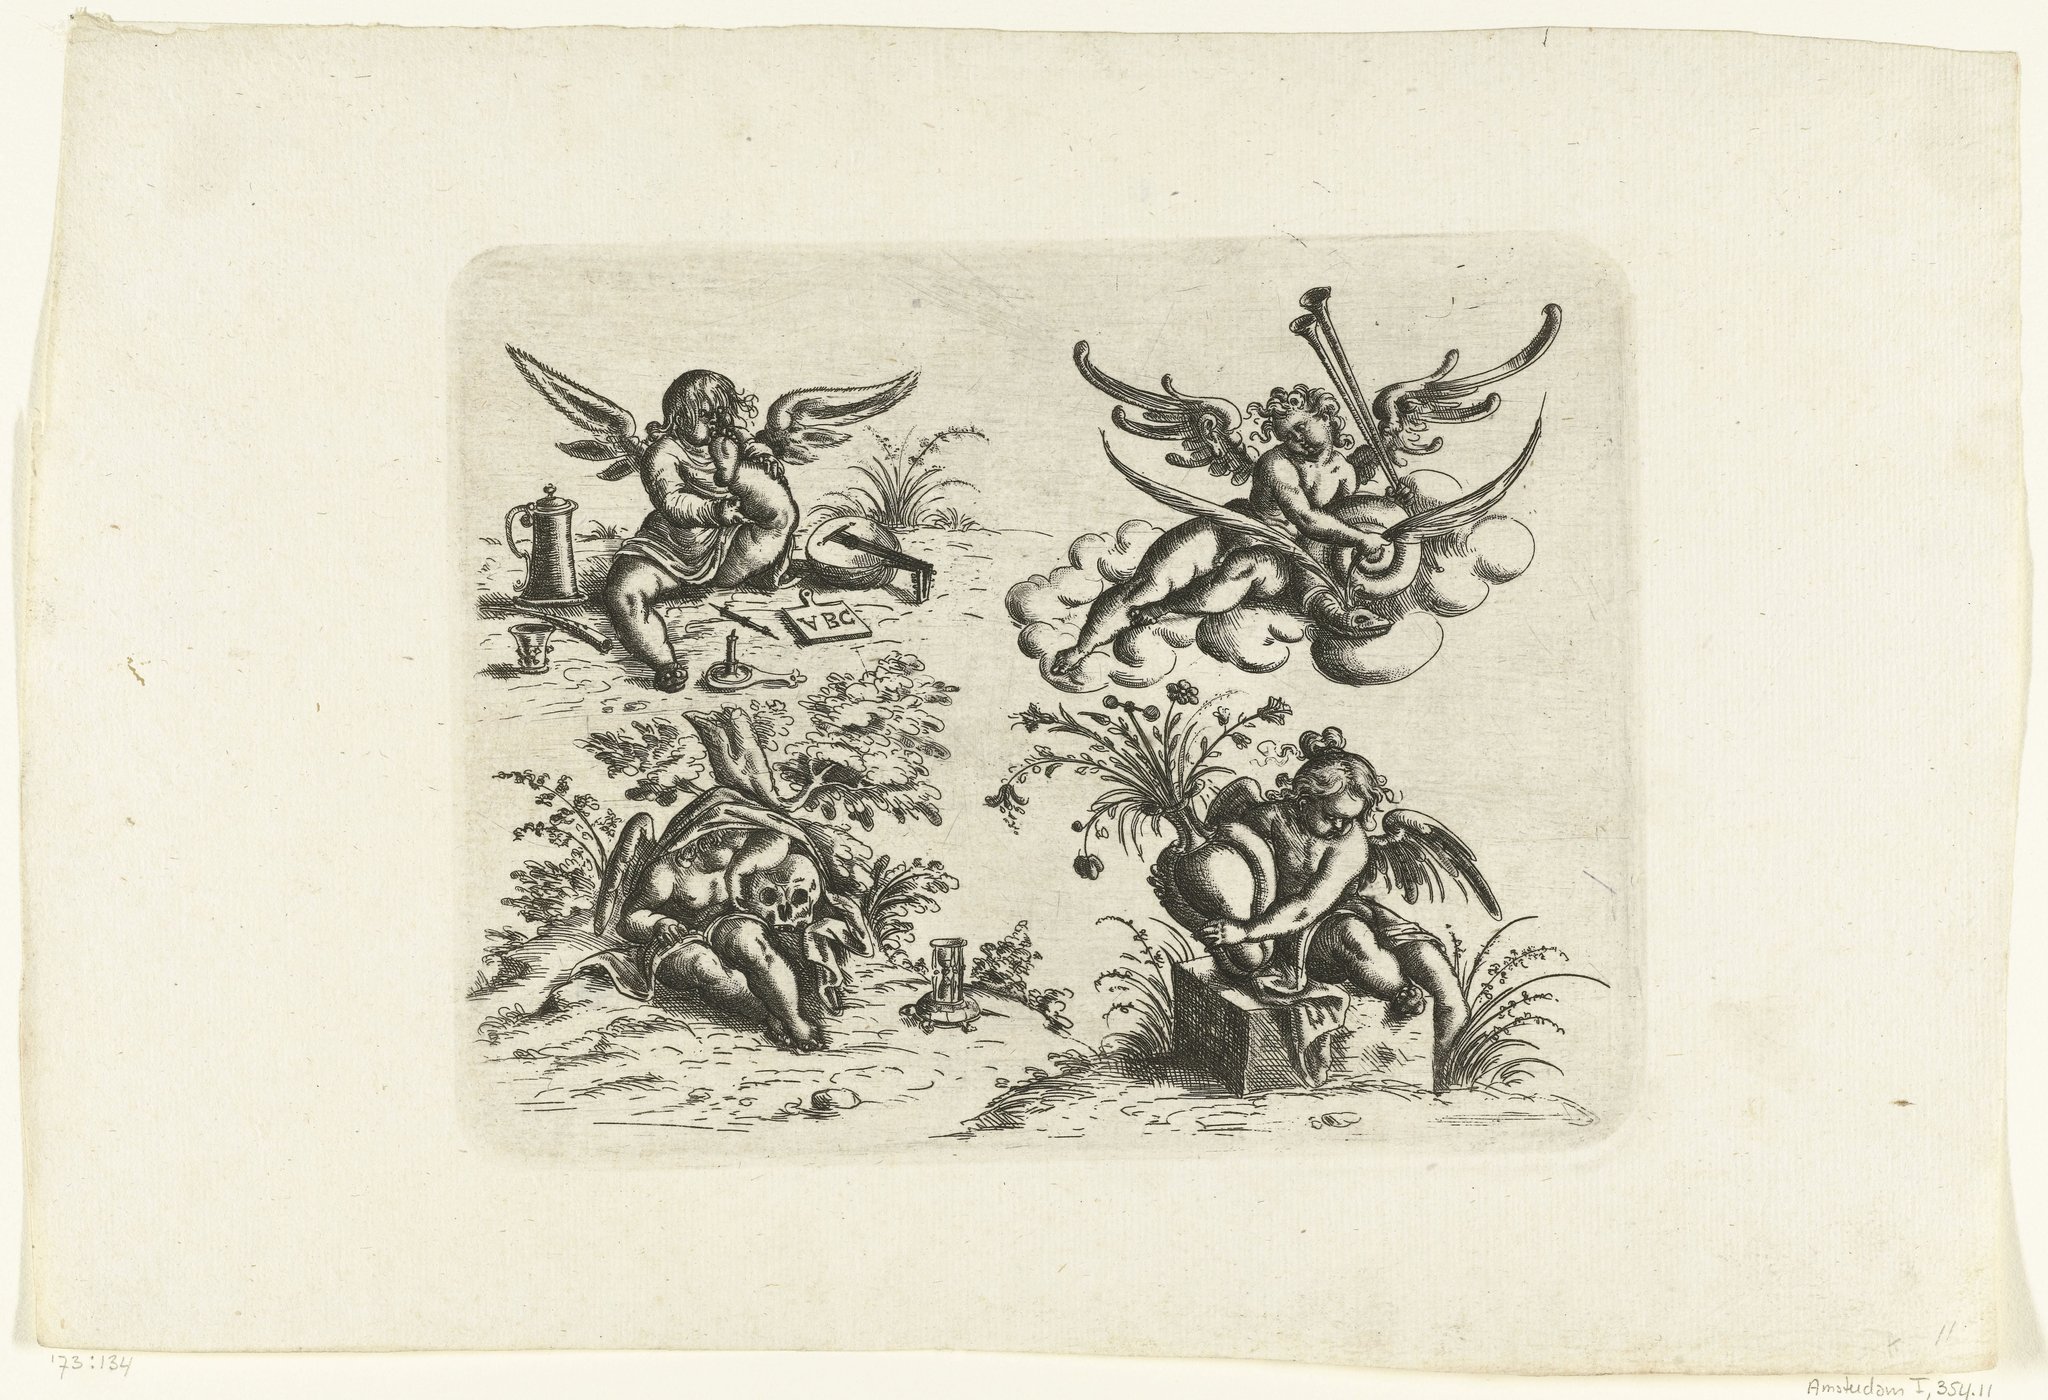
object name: print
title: Vier putti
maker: christoph jamnitzer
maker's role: draughtsman, goldsmith, print maker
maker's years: 1563-1618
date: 1573-1610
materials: paper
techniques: etching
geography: germany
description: Linksboven zit een putto op de grond met één been omhoog tussen een kan, een beker, een blaker, een schrijftafeltje en een luit. Rechtsboven ligt een putto op een wolk met twee bazuinen in de hand. Blad uit een serie vlakdecoraties met grotesken, cartouches, ovalen, mascarons, putti en fantastische wezens. De serie bestaat uit drie titelbladen, twee tekstbladen met de opdracht en het voorwoord en 60 bladen, verdeeld over drie boeken.